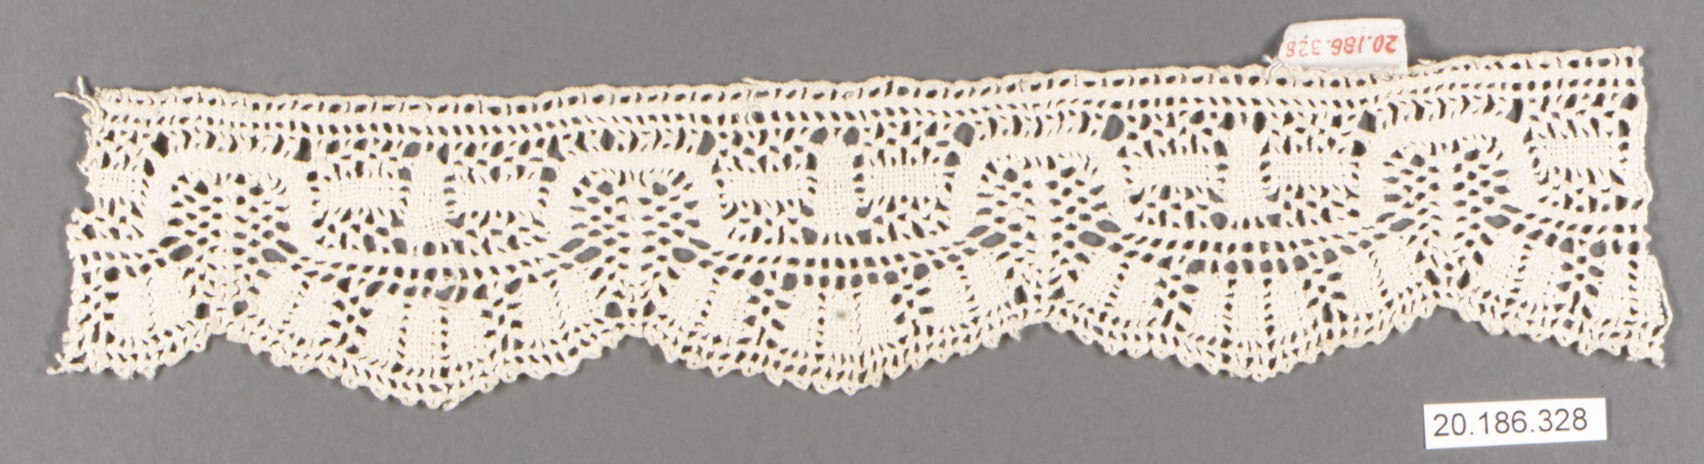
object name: edging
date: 1701-1800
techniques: lace